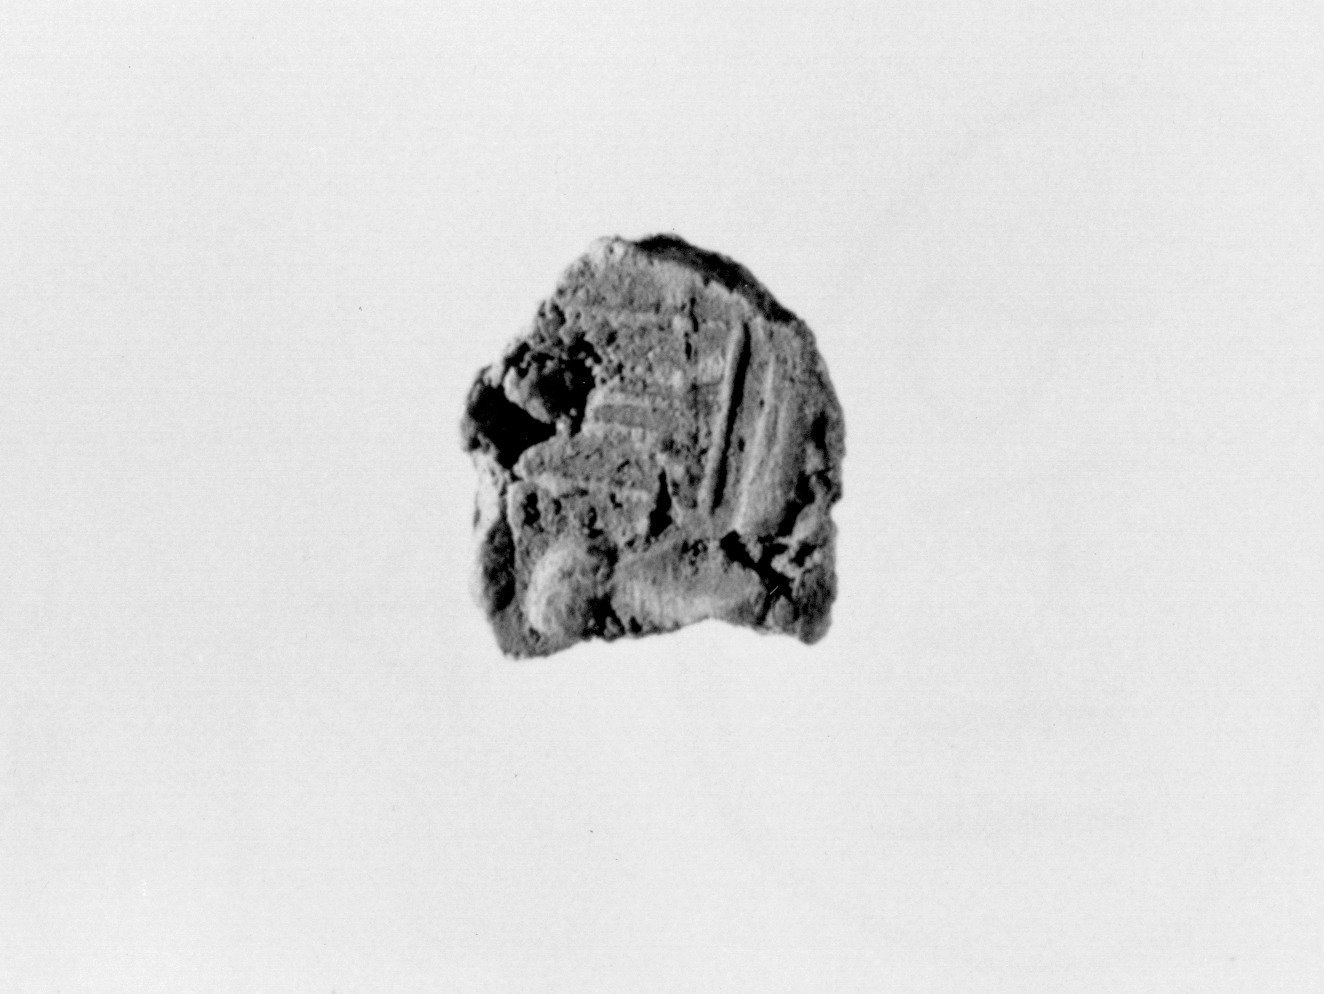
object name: sealing, nebmaatre, amenhotep iii, heb sed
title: Document Sealing With the Throne Name of Amenhotep III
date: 1390-1352 BCE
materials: mud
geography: egypt